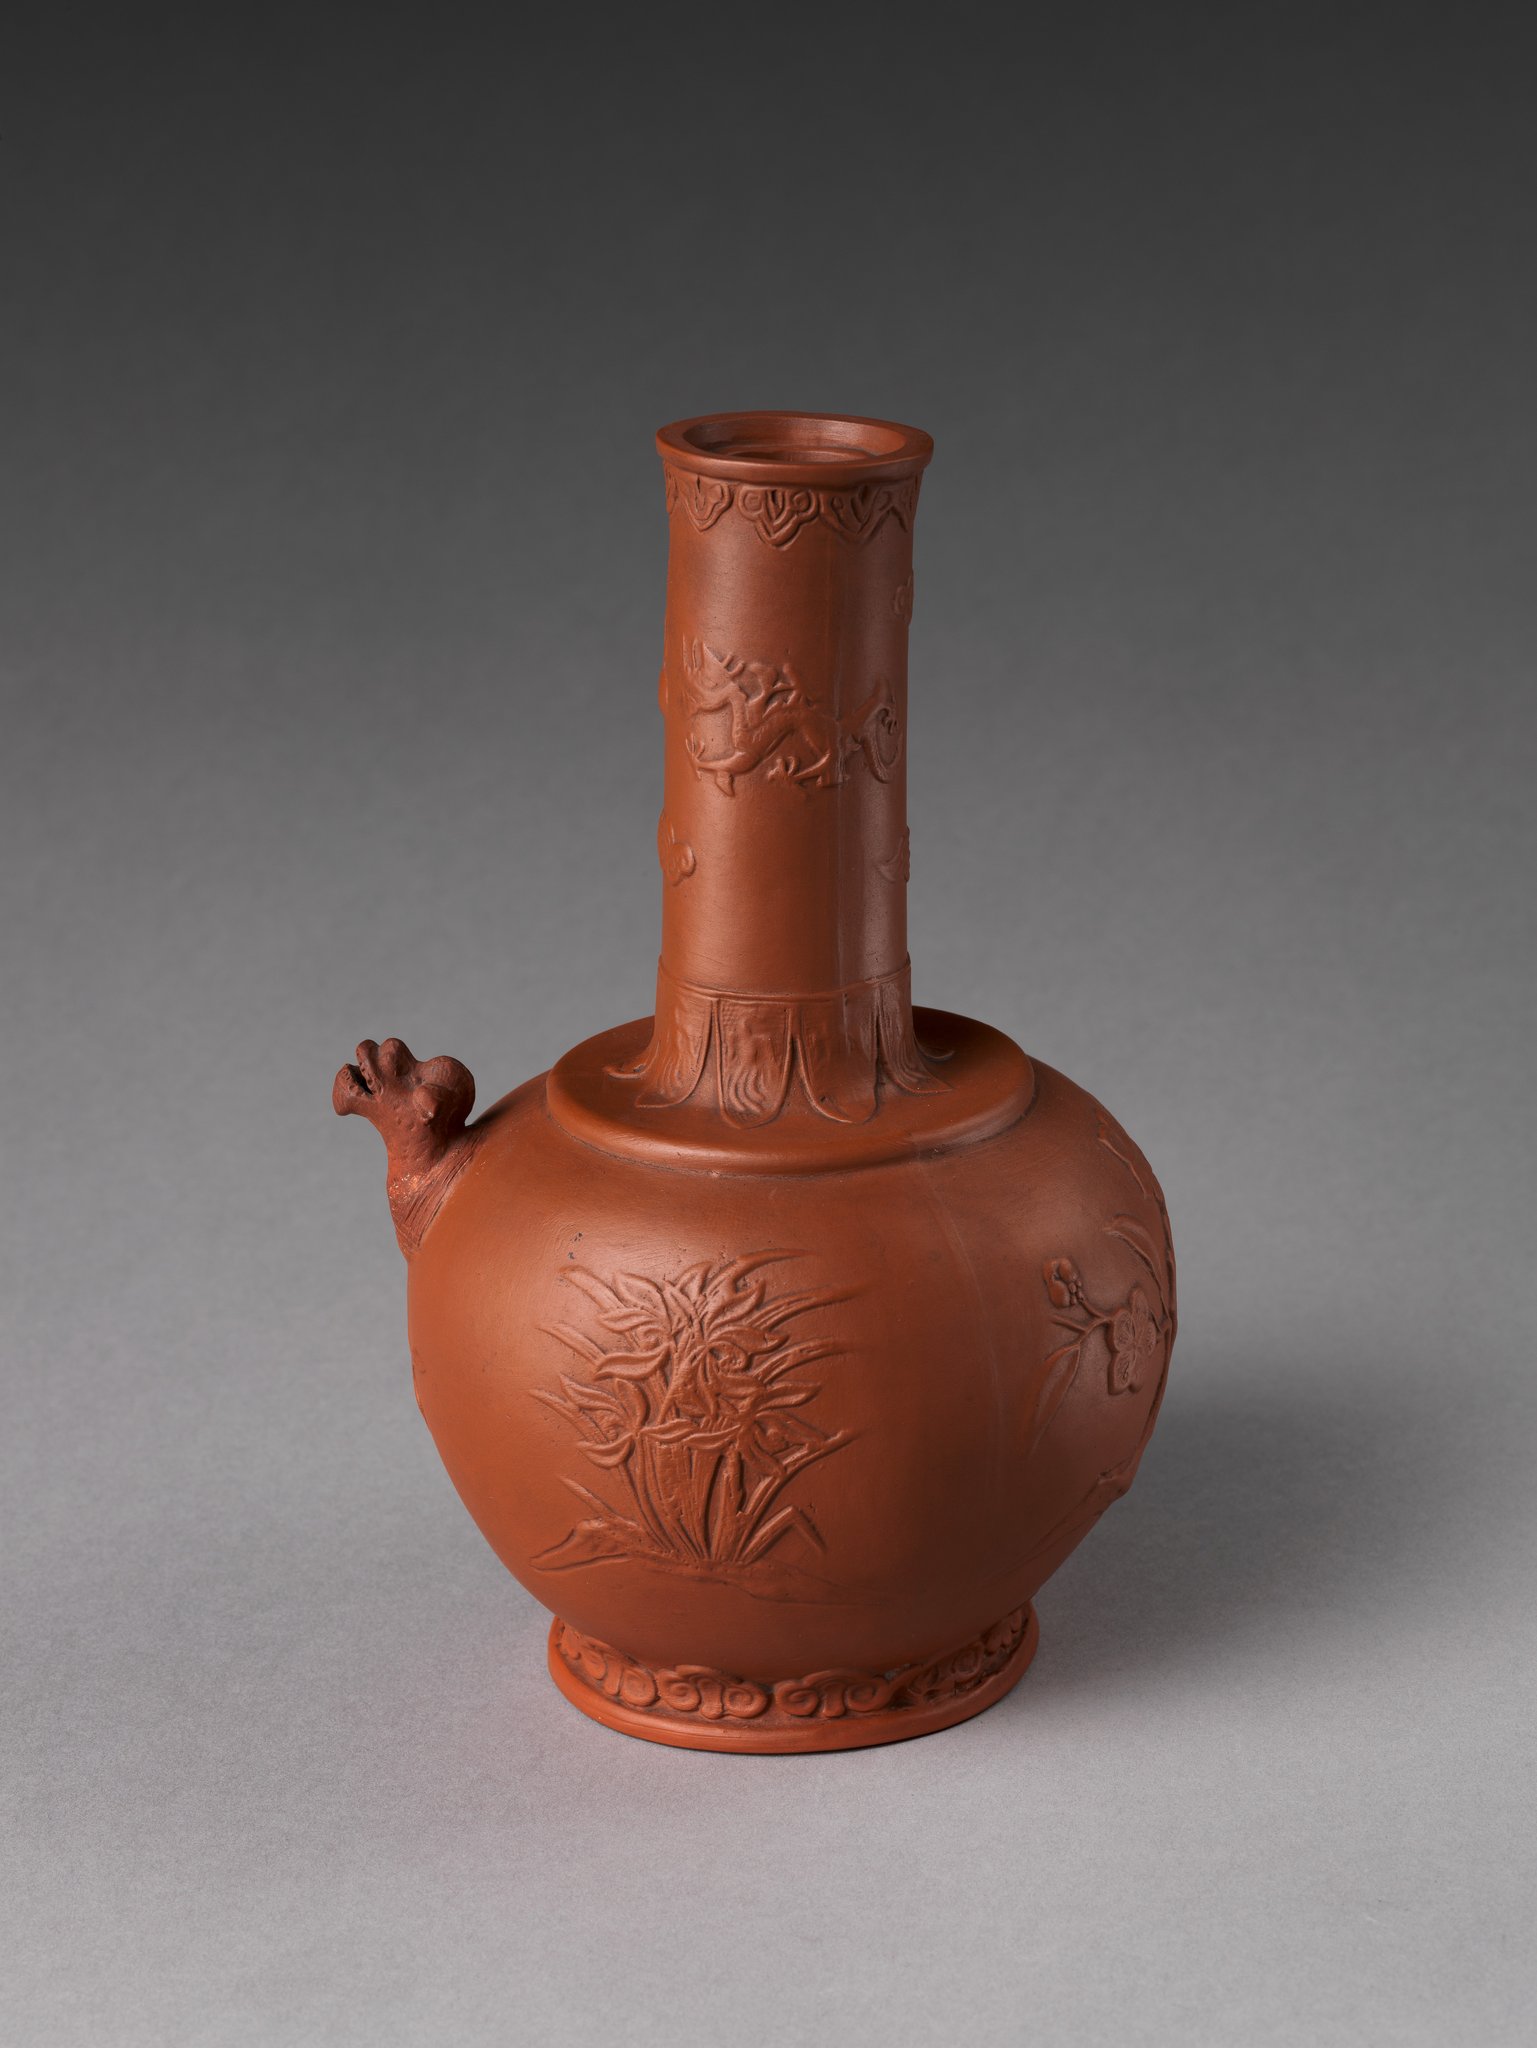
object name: pouring vessel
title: Pouring vessel (Kendi)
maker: meissen manufactory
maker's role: manufactory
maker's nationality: german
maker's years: 1710-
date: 1710-1712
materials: stoneware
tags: dragons,flowers